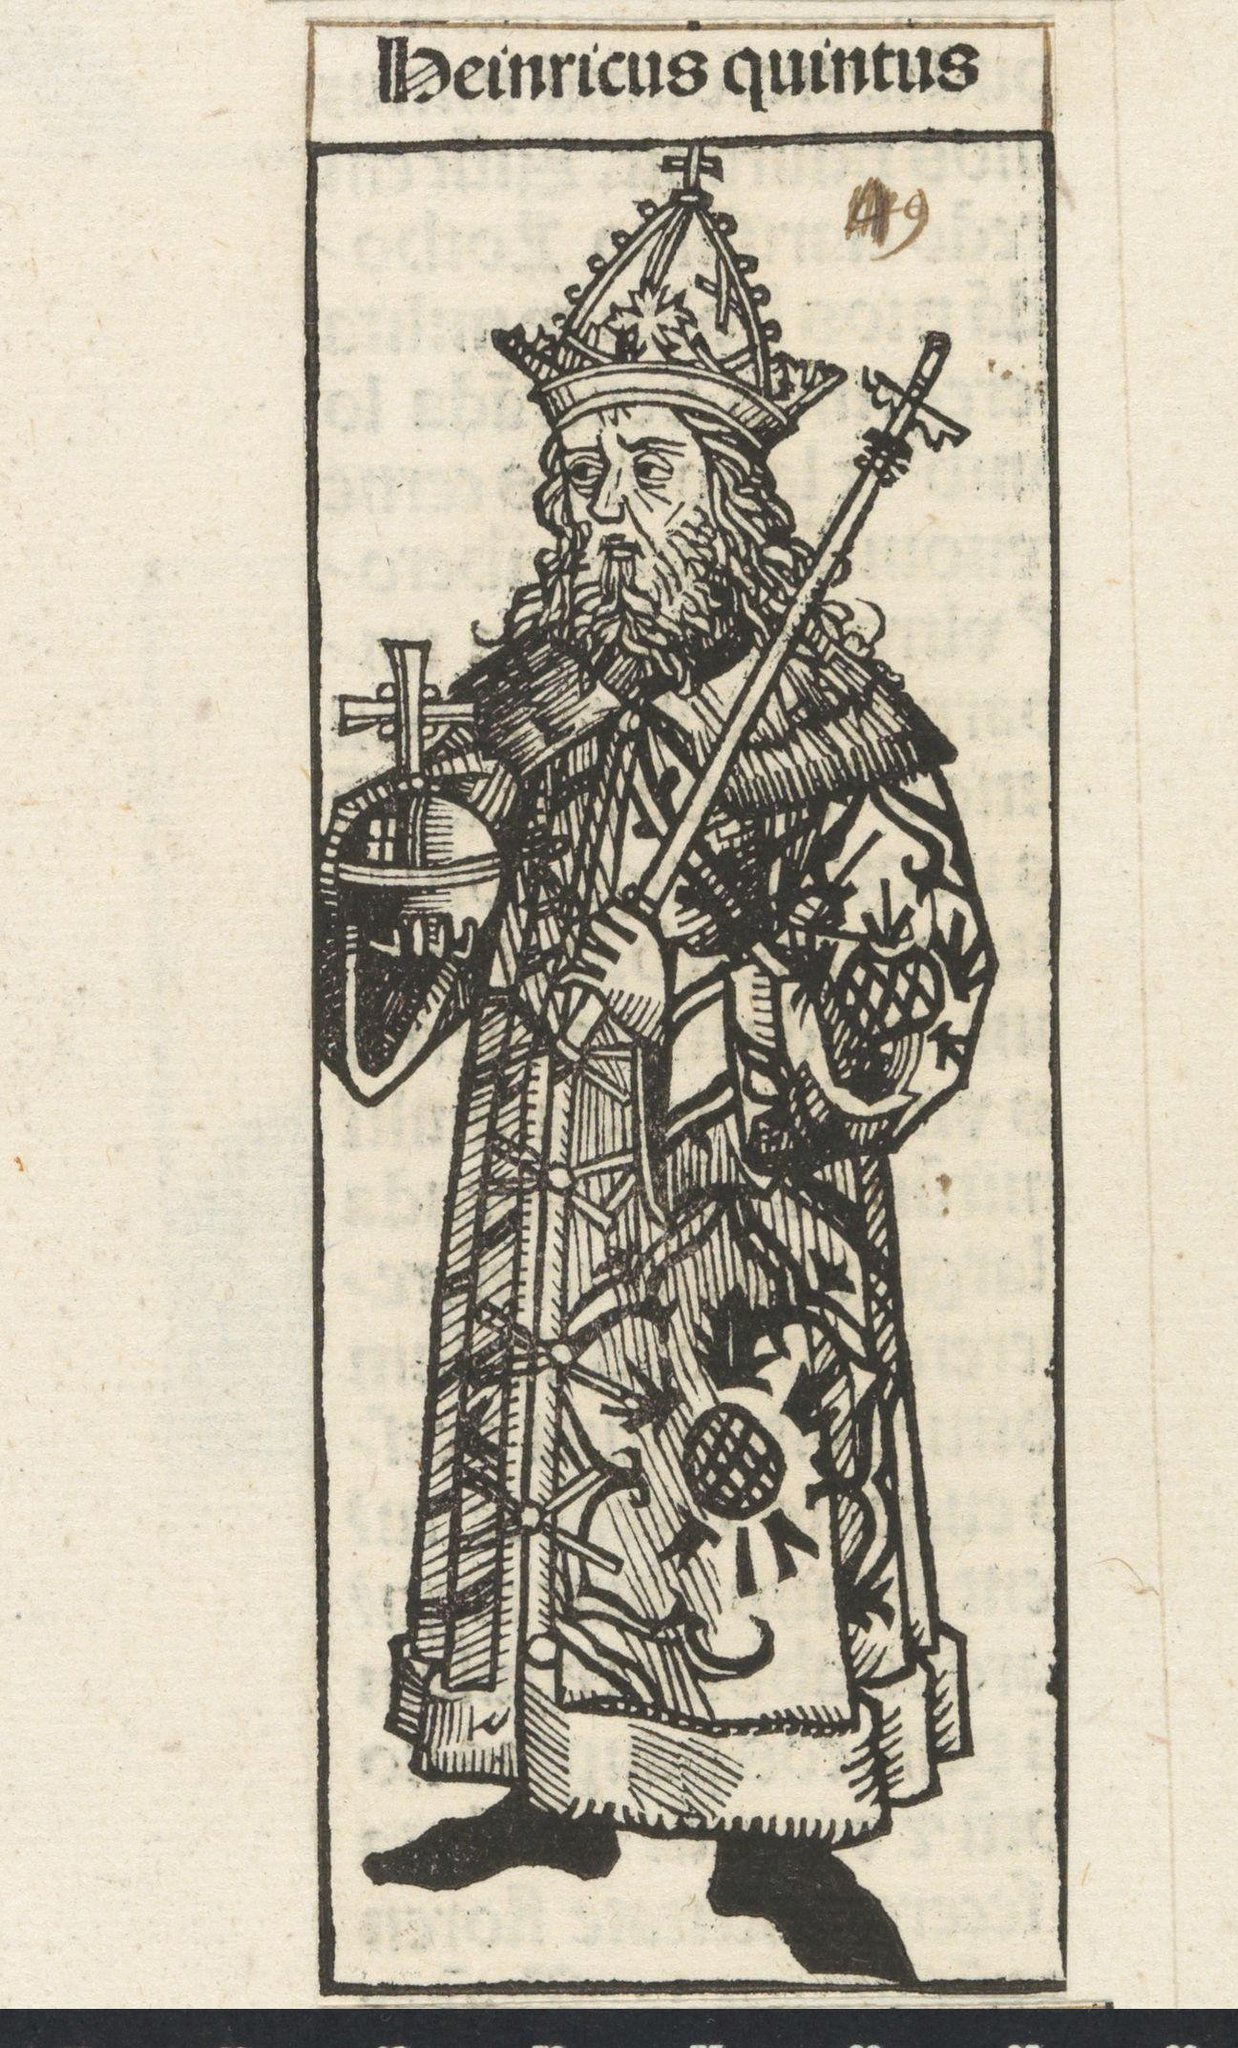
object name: album leaf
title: Keizer Hendrik V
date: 1493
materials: paper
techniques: letterpress printing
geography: nuremberg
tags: utrecht, emperor, king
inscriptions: inscription: ‘49’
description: Een koning met rijksappel en scepter, ten voeten uit. De voorstelling is onderdeel van de opeenvolging keizers in de Liber Chronicarum. De tekst identificeert de man als keizer Hendrik V. De prent maakt deel uit van een album.